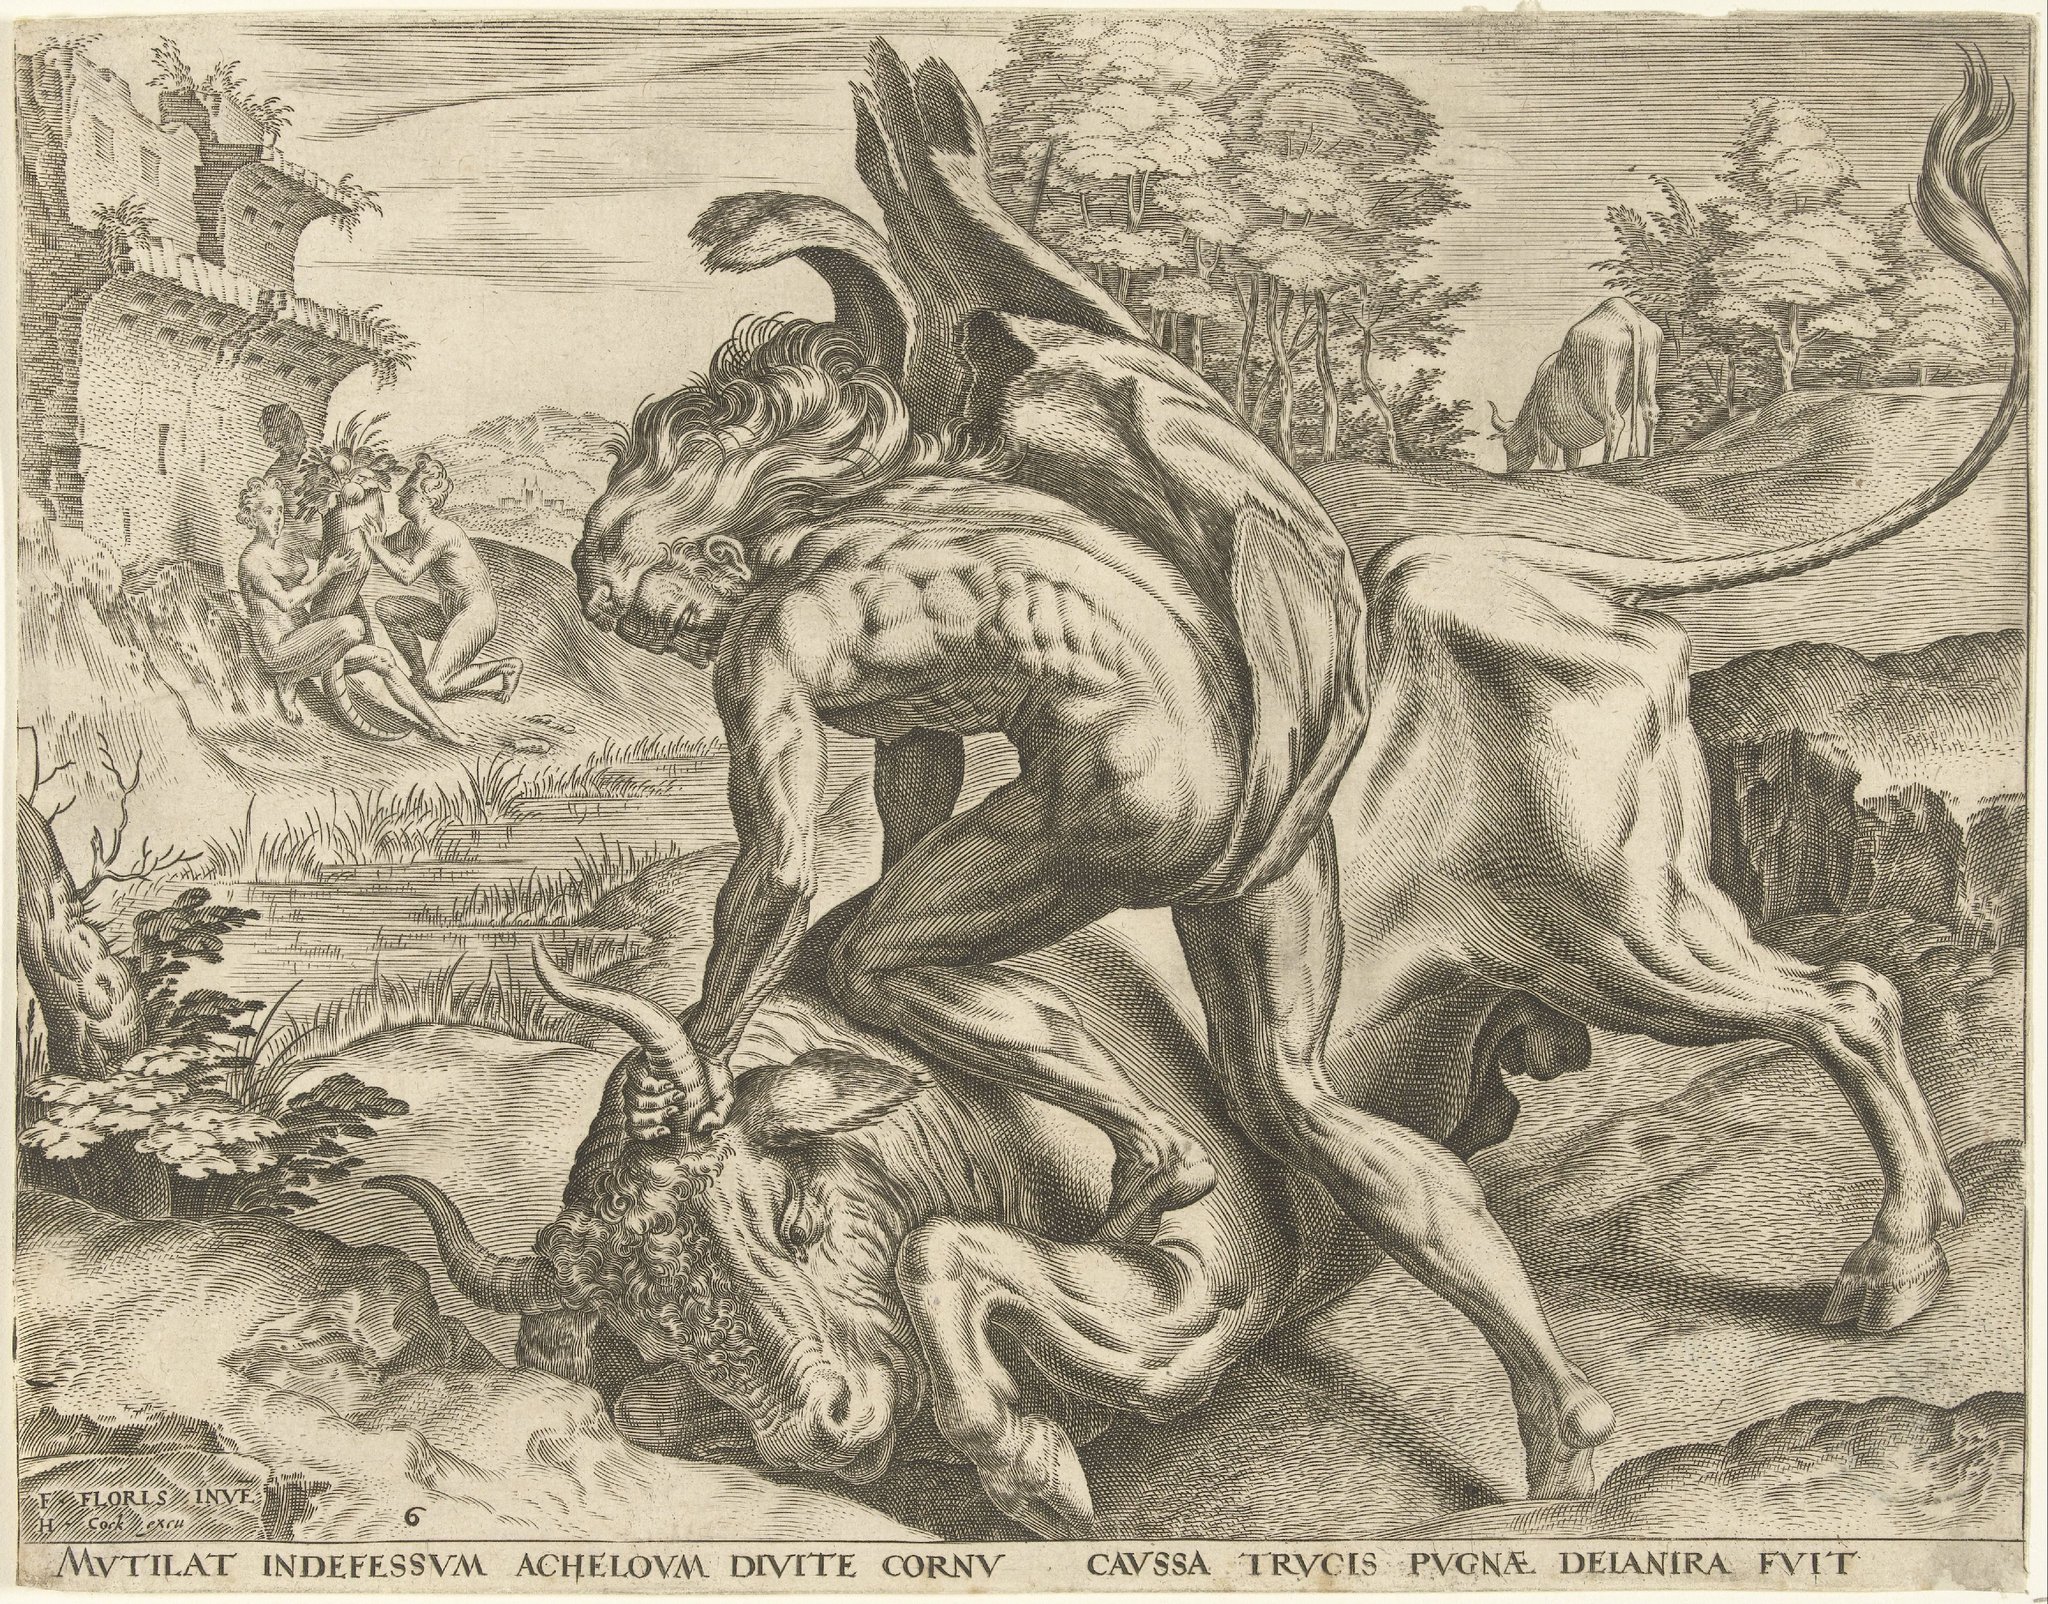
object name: print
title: Werken van Hercules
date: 1563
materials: paper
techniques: engraving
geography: antwerp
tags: while fighting with hercules the river-god achelous changes himself into a bull, or a bull-headed man, hercules breaks off a horn; naiads fill the horn with flowers and fruits; it thus becomes the cornucopia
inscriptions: collector's mark: Lugt 10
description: Hercules vecht met de riviergod Acheloüs die de gedaante van een stier aangenomen heeft. Het gaat om de gunst van Deïanira de dochter van de riviergod Oeneus. Hercules breekt de stier de horens af. Op de achtergrond is te zien hoe nimfen een van de horens vullen en gebruiken als hoorn des overvloeds.